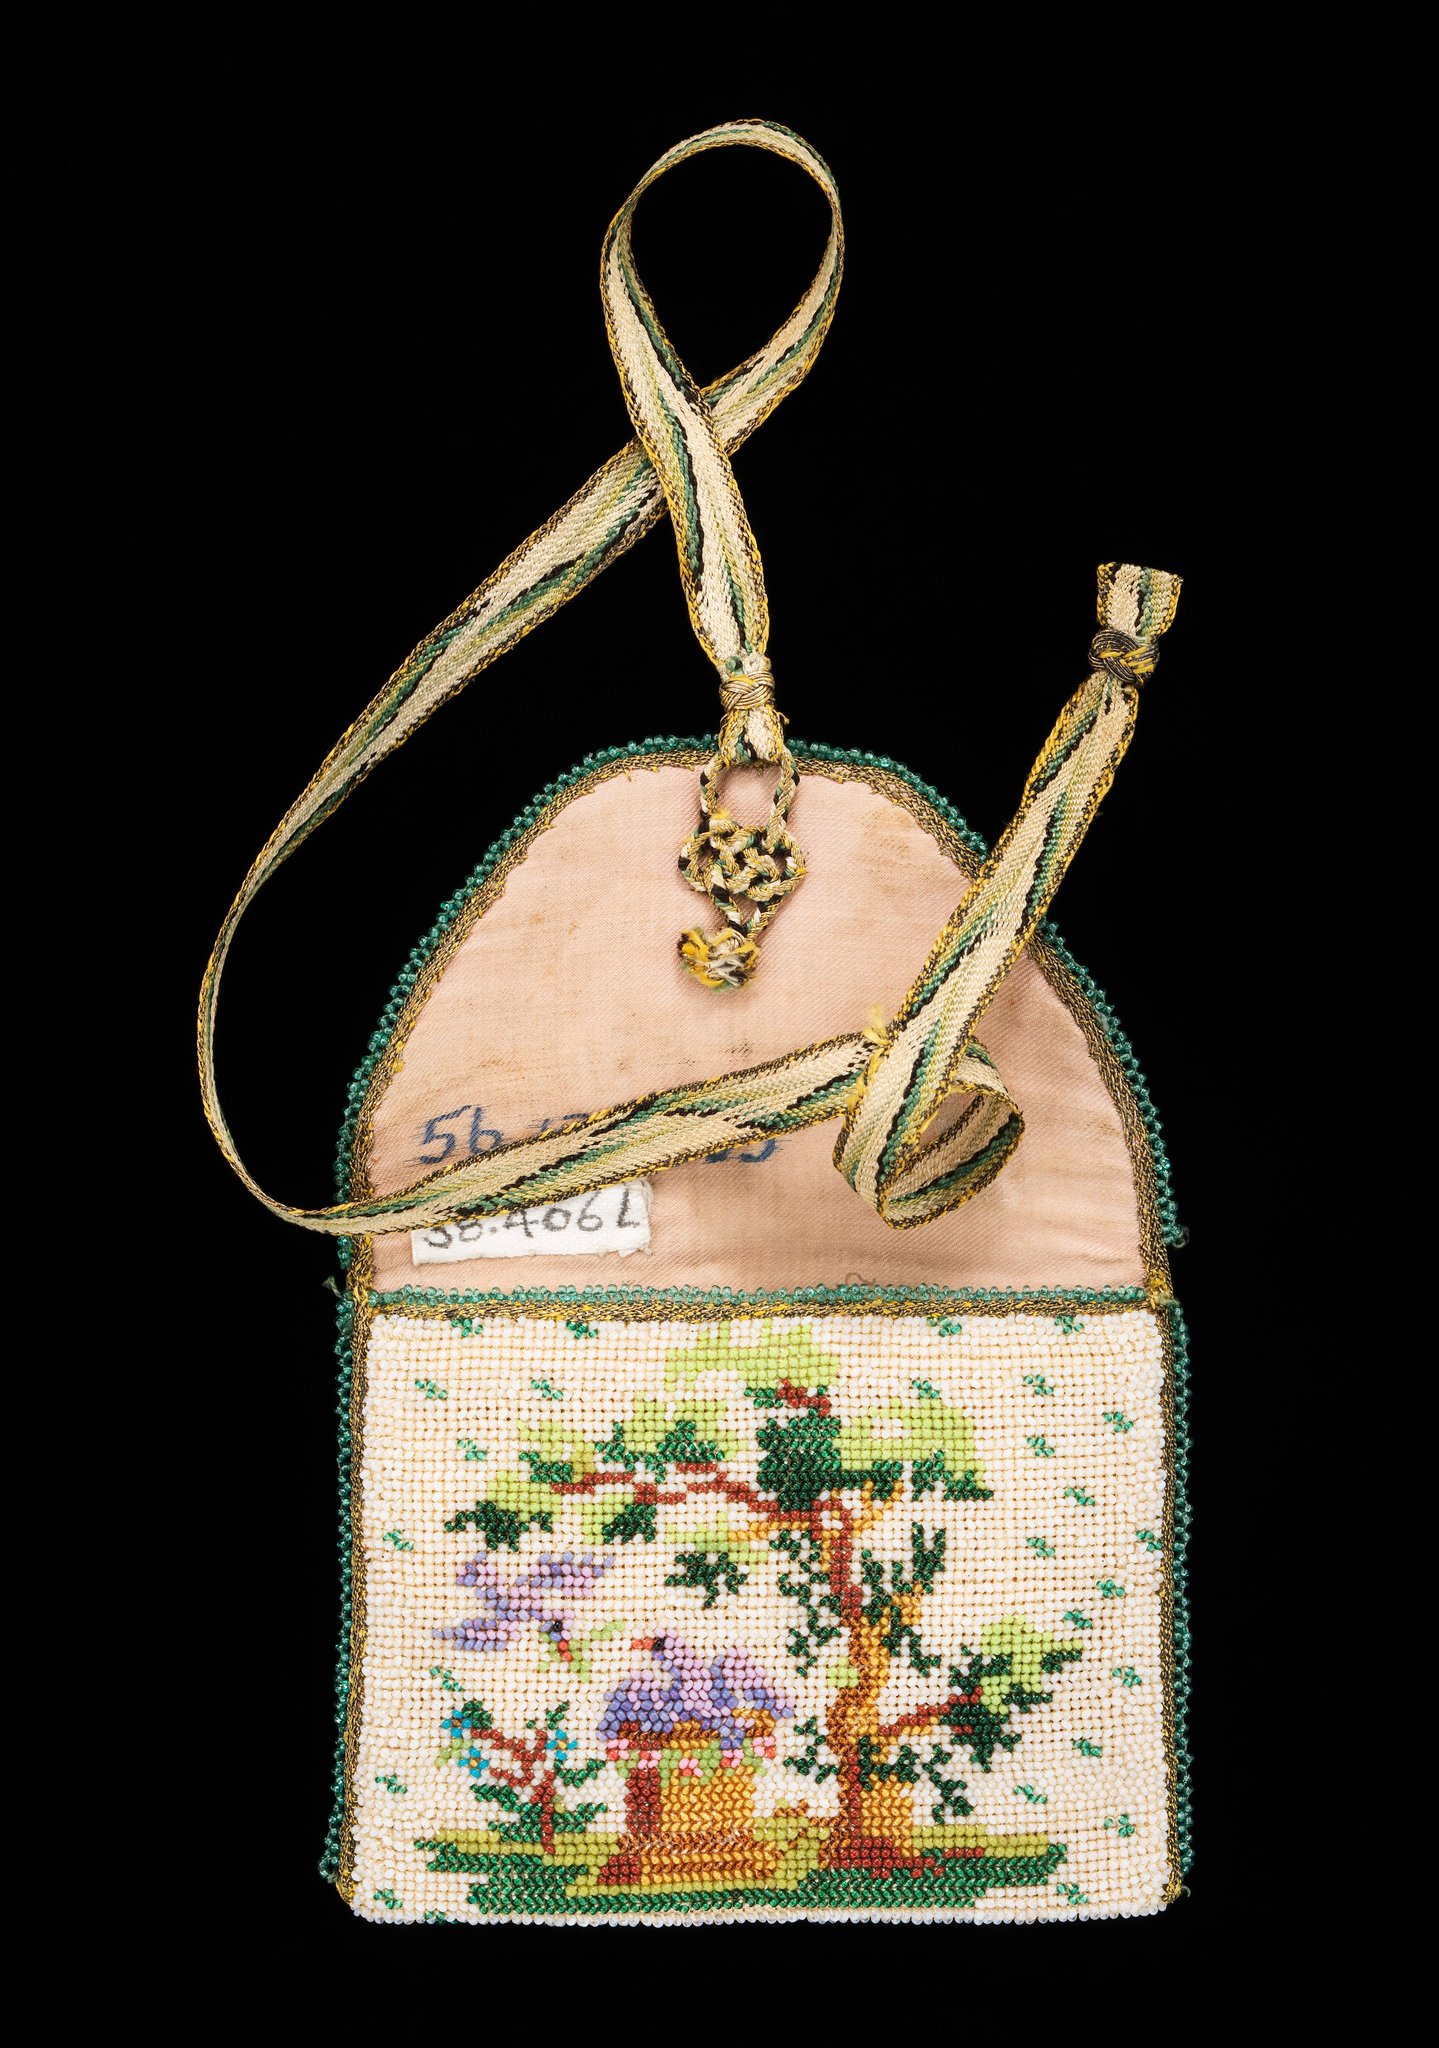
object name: coin purse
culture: mexican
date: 1820-1840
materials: glass, linen, metal, silk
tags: birds,sheep